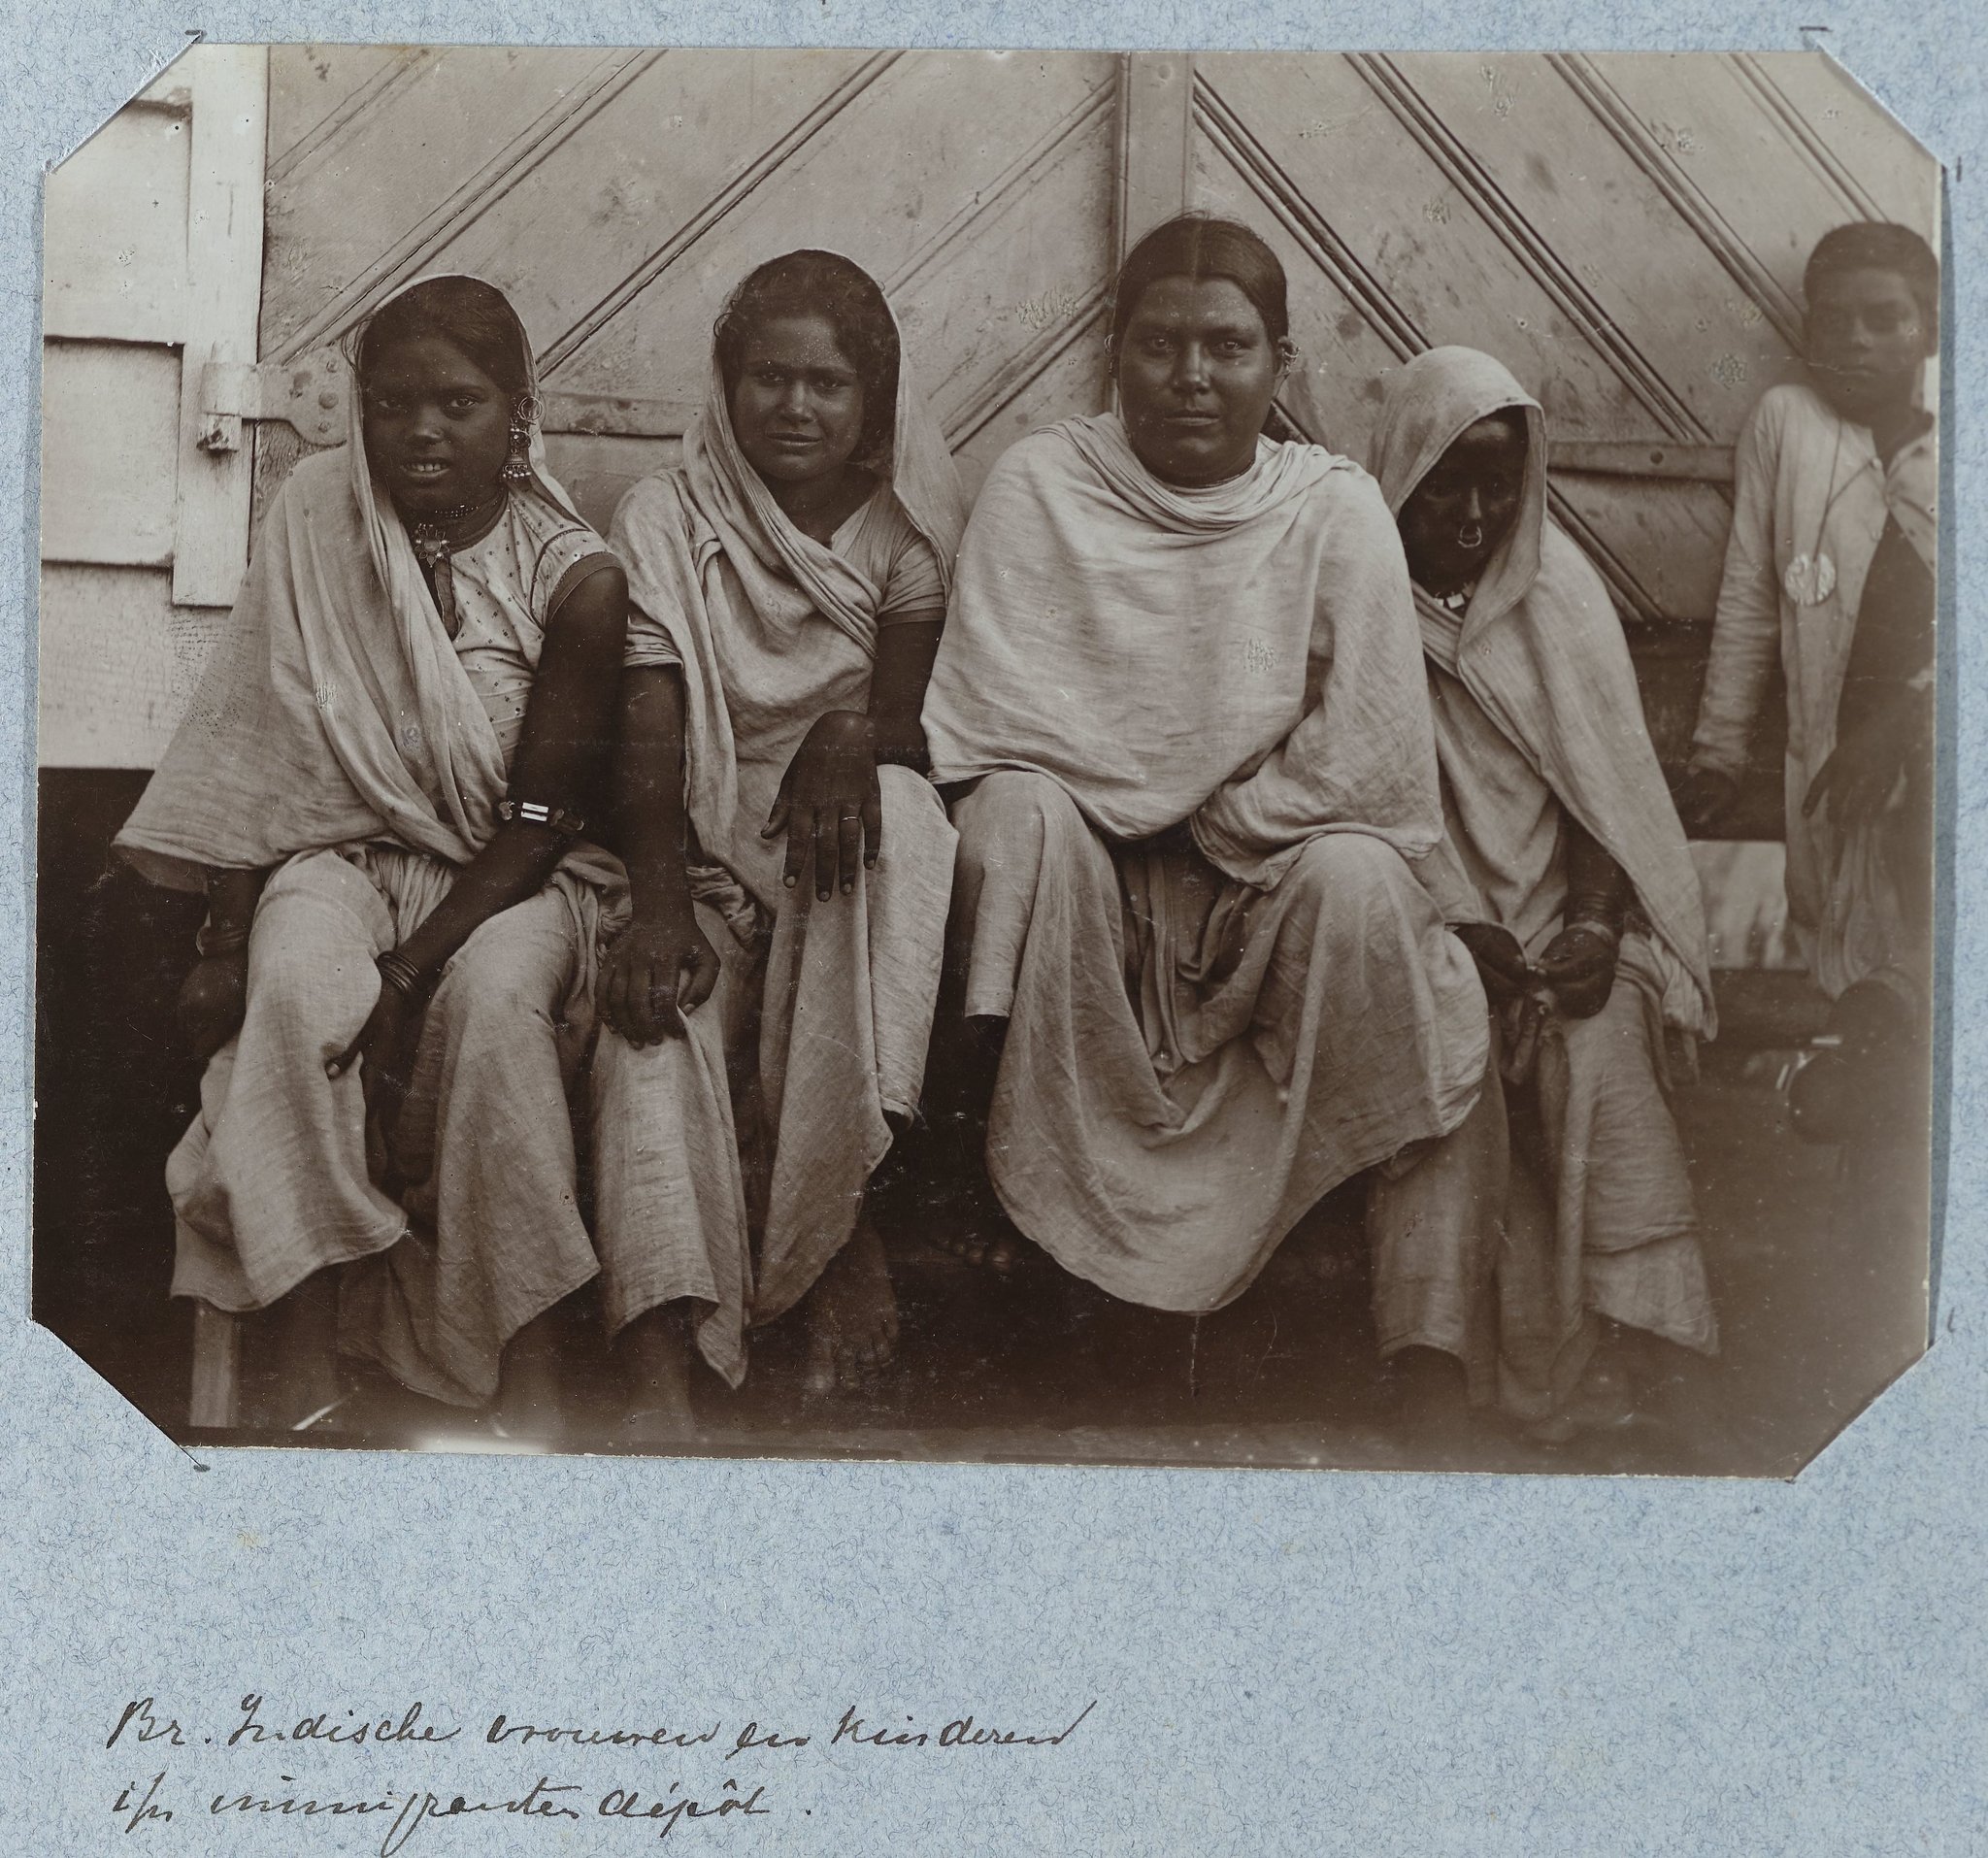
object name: photograph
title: Female Indentured Labourers in the Depot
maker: théodore van lelyveld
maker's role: painter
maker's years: 1867-1954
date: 1895-1898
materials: photographic support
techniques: collodion silver print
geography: suriname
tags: migrants, working class, labourers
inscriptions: inscription: ‘Br. Indische vrouwen en kinderen i/h immigranten dépôt / Oemraisie [?]’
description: Here the women wear the white saris (robes) they received when they left Kolkata, and a few hold a hookah (tobacco waterpipe). Visitors are allowed on Sundays. These are mostly Hindustanis looking for relatives, a spouse or news from India. Photographer Van Lelyveld also visits the depot. He notes the name of one woman, ‘Oemranie.’